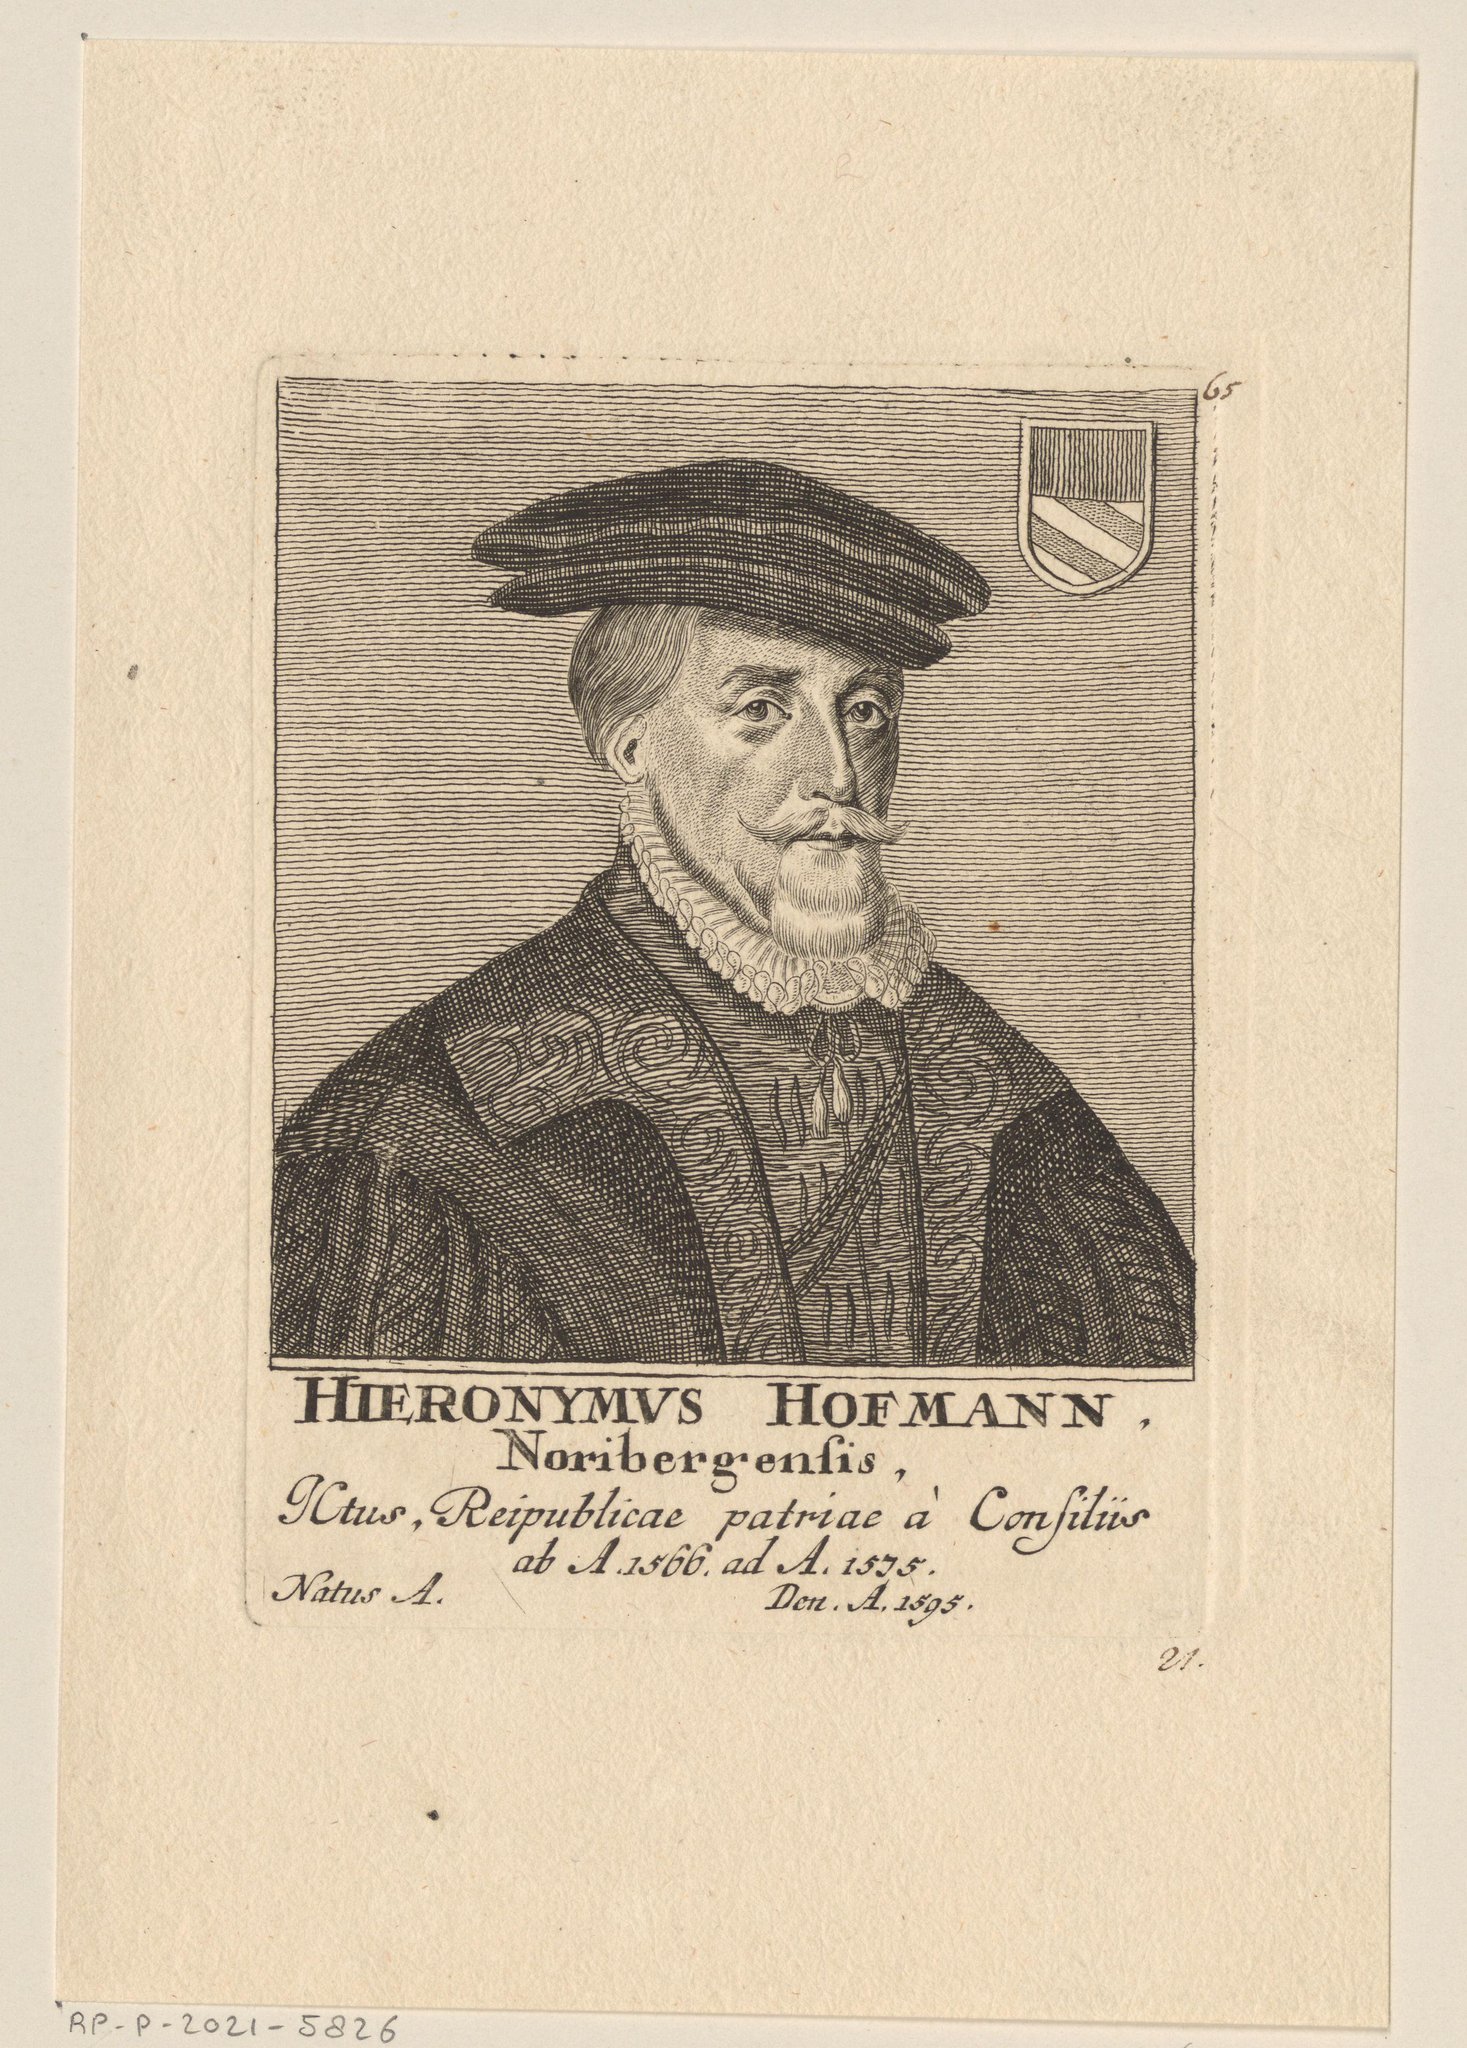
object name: print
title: Portret van Hieronymus Hofmann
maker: Anonymous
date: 1700-1749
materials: paper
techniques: engraving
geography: nuremberg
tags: historical persons, armorial bearing, heraldry